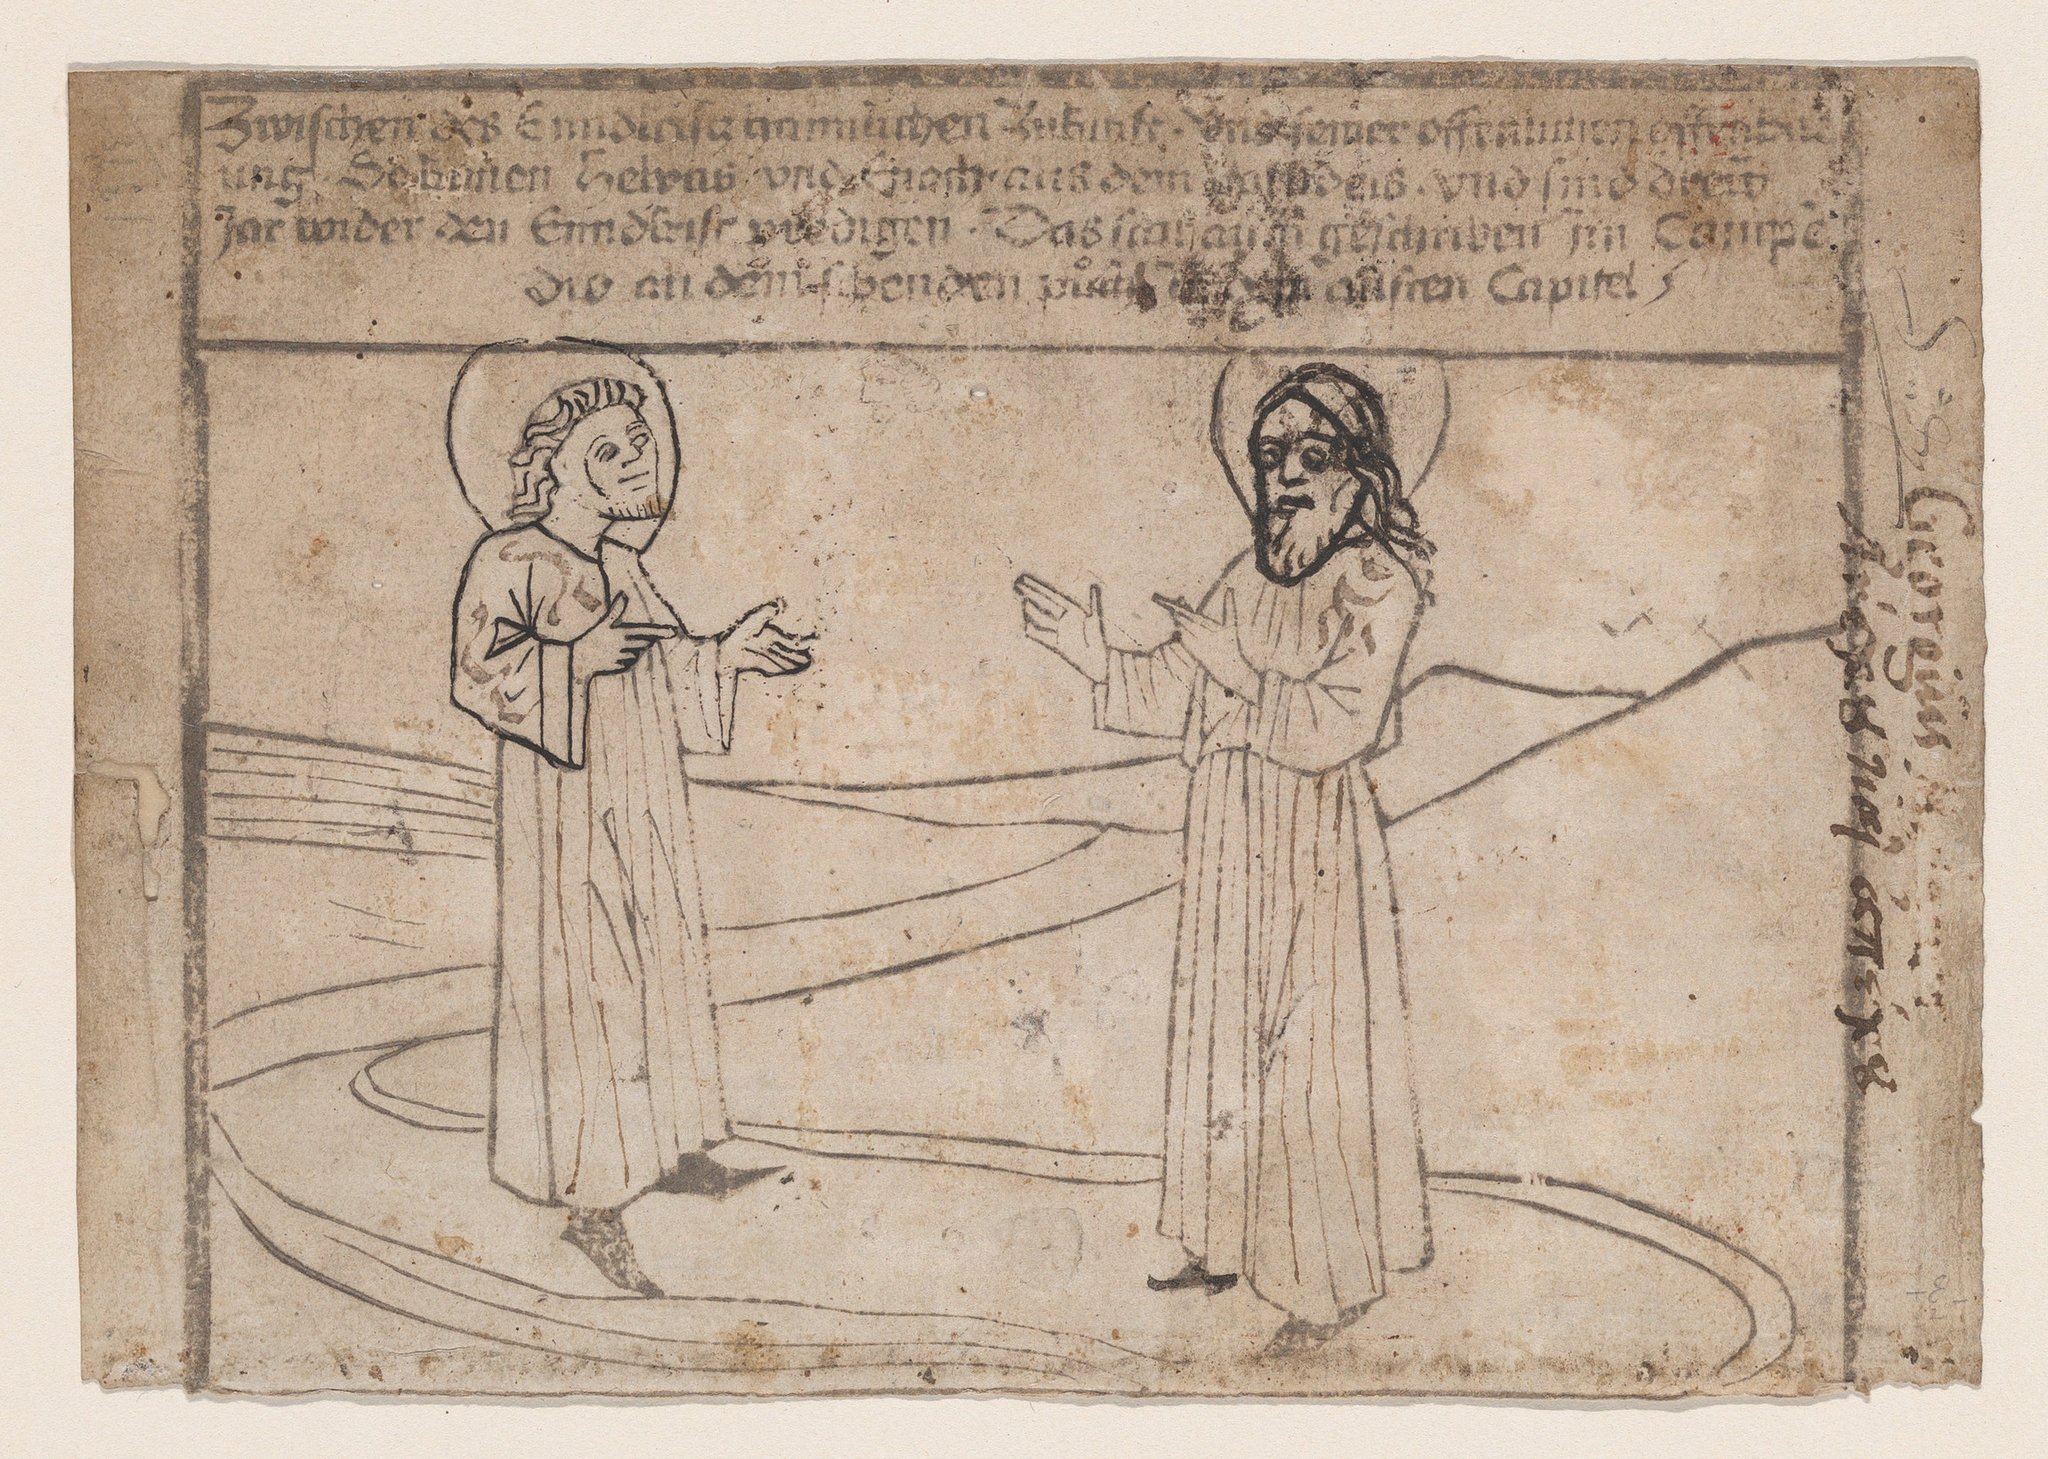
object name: print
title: Elias and Enoch Descend from Heaven, from a "Quindecim signa extremi judicii diem praecedentia" (Antichrist and the Fifteen Signs) blockbook, first edition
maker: anonymous, german, 15th century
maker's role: artist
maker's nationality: german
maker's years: 1400-1500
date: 1465-1475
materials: ink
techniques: printing, woodcut